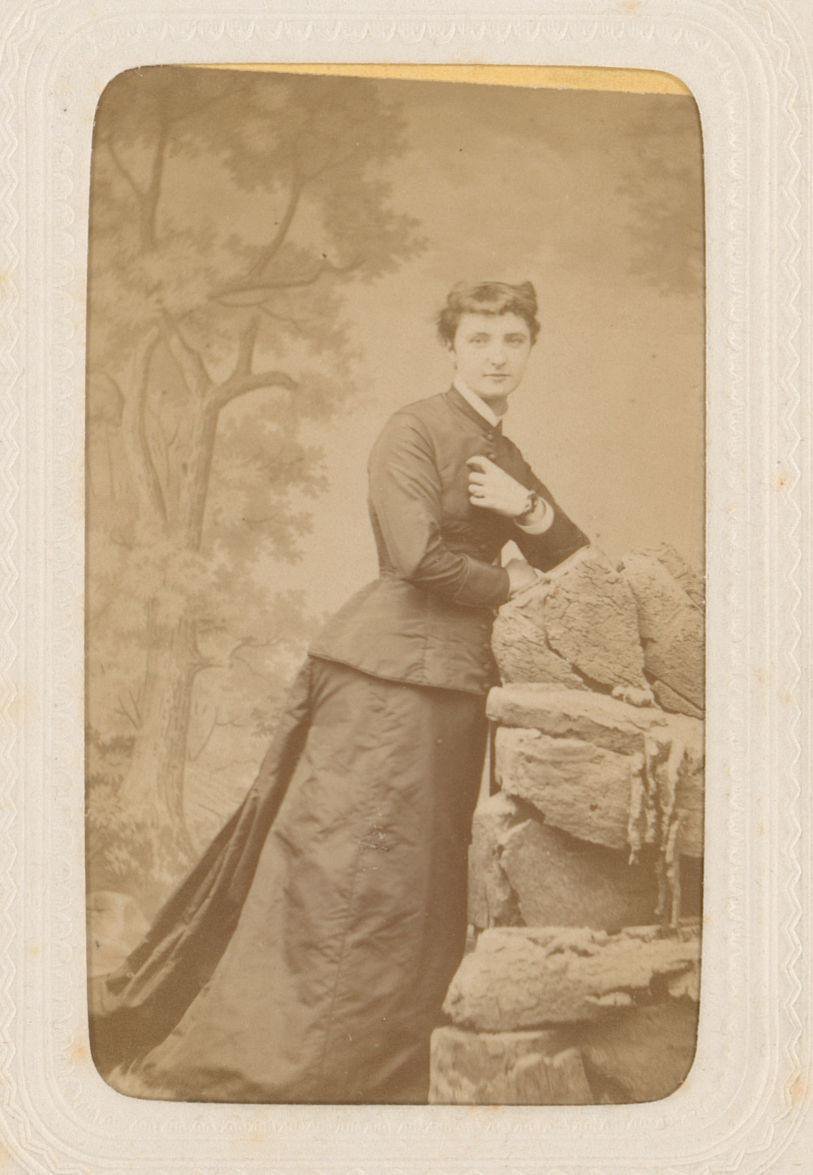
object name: carte de visite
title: Studioportret van een jongevrouw voor een landschapschildering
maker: albert prouzet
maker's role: fotograaf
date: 1863-1866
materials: cardboard, paper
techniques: albumen print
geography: paris